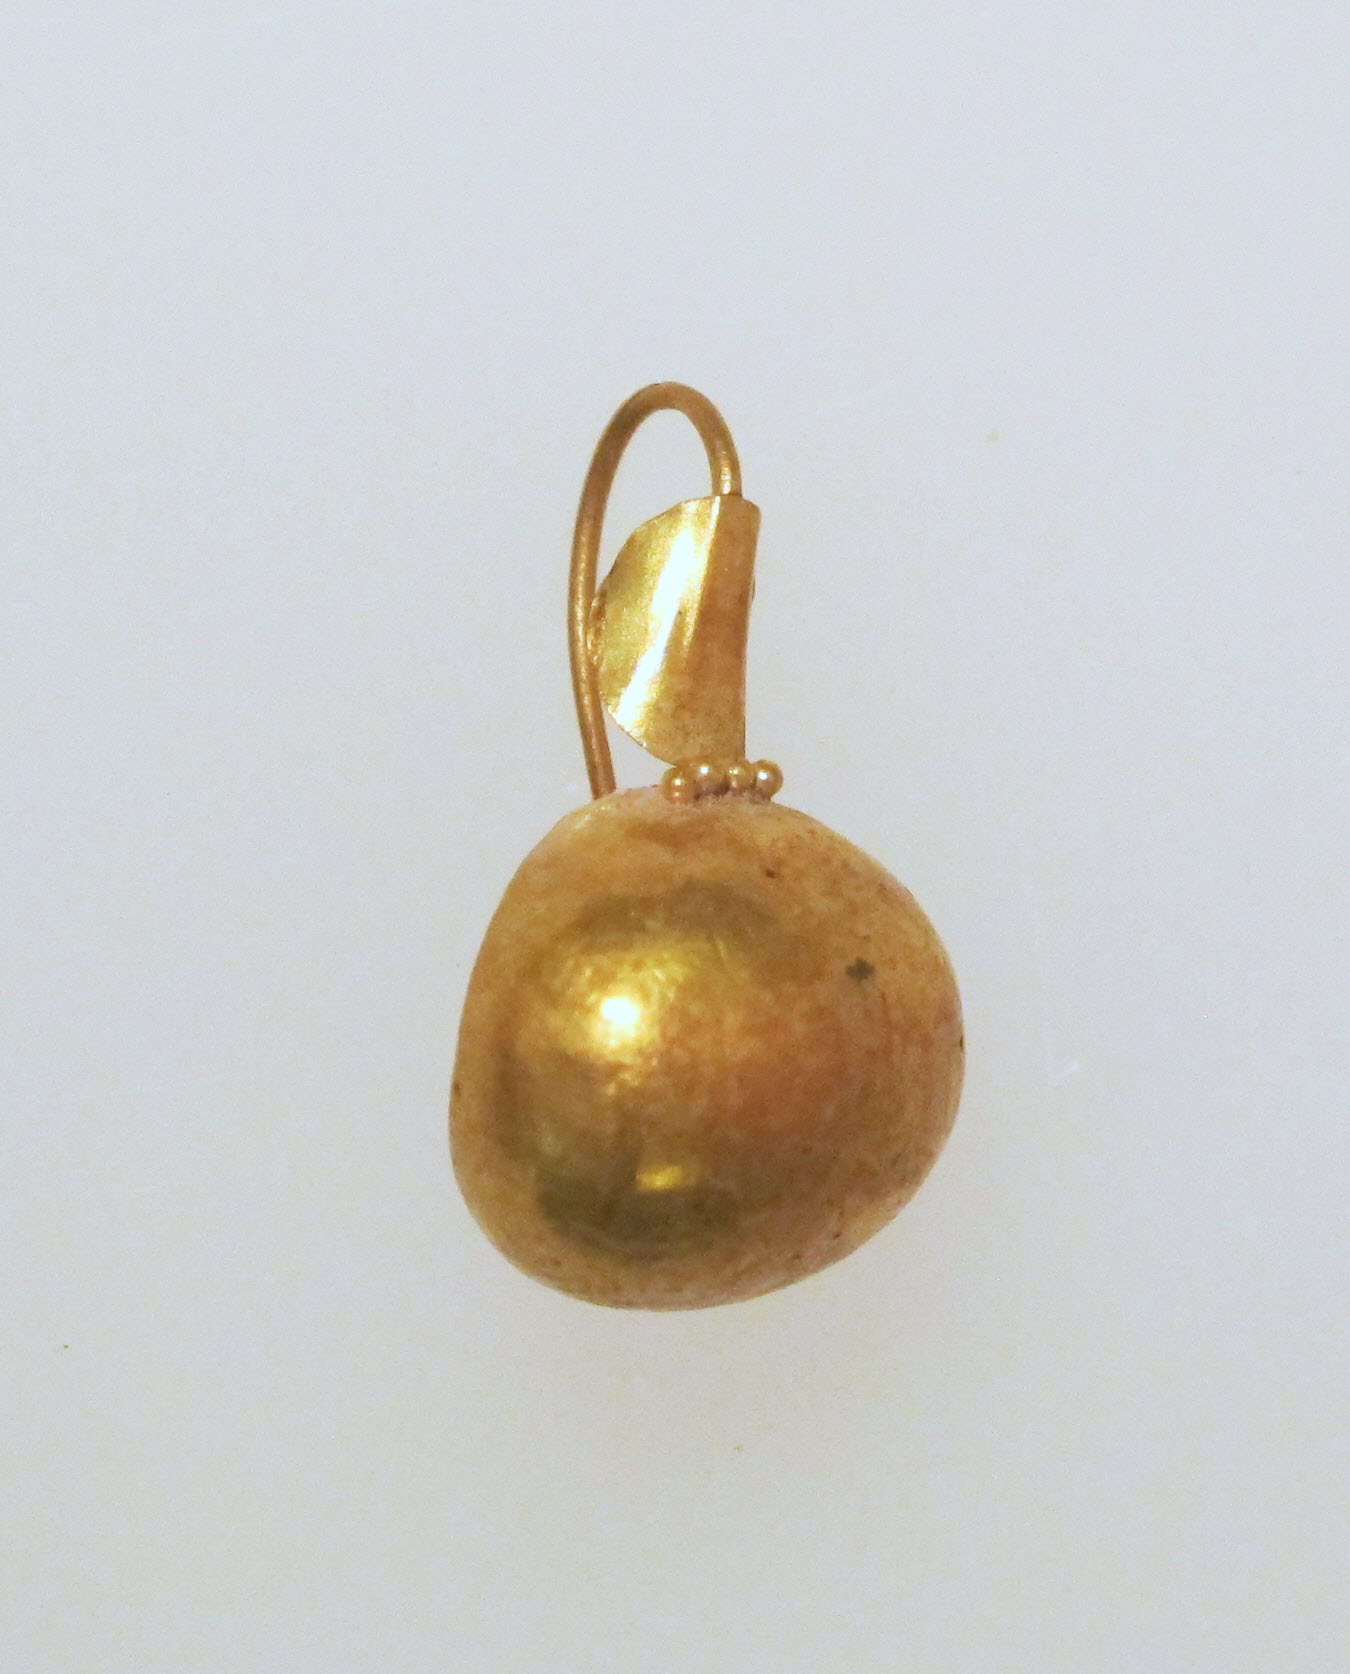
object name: earring hook type with sphere end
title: Earring-hook type with sphere ends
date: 7000 BCE-330 CE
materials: gold